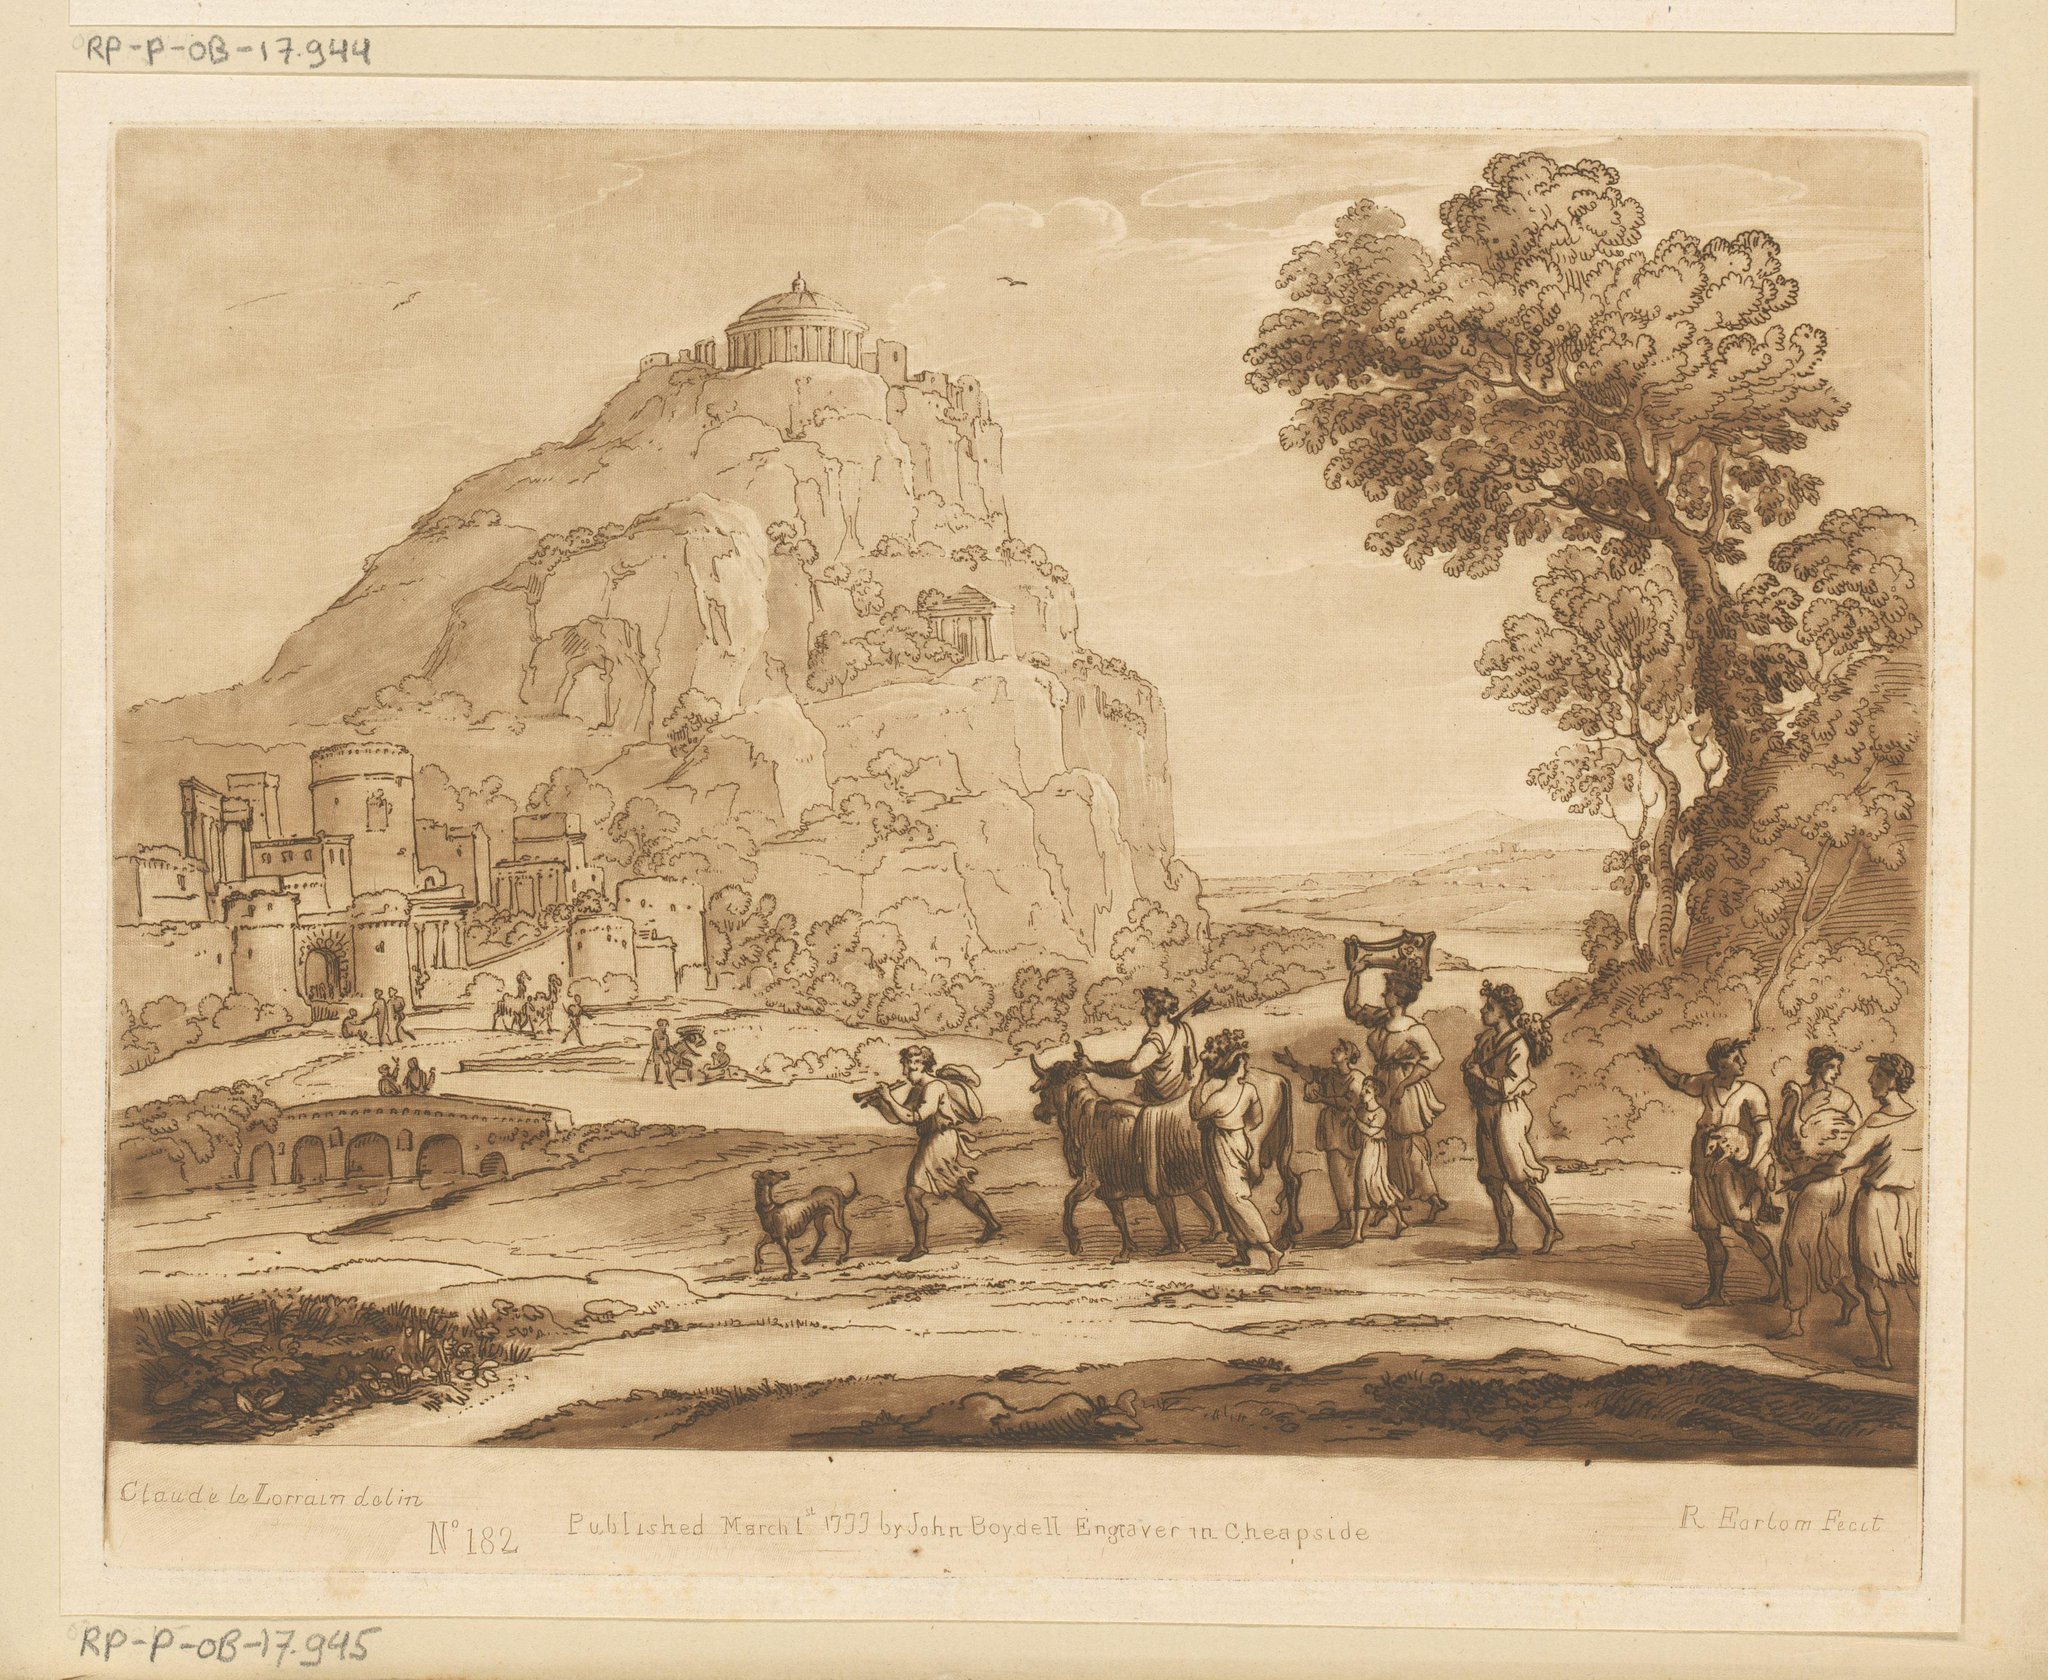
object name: print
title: Landschap met gezicht op Delphi en processie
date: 1777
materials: paper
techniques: etching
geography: london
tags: city-view, and landscape with man-made constructions - ii - ideal landscapes, places and objects of worship ~ non-christian religions, landscape with bridge, viaduct or aqueduct - ii - ideal landscapes, mountains - hh - ideal landscapes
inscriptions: date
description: Vanaf 1774 publiceerde John Boydell tweehonderd prenten naar het tekeningenboek Liber Veritatis van Claude Lorrain, in het bezit van de hertogen van Cavendish. Deze prenten werden vanaf 1777 in twee volumes gebundeld uitgegeven.